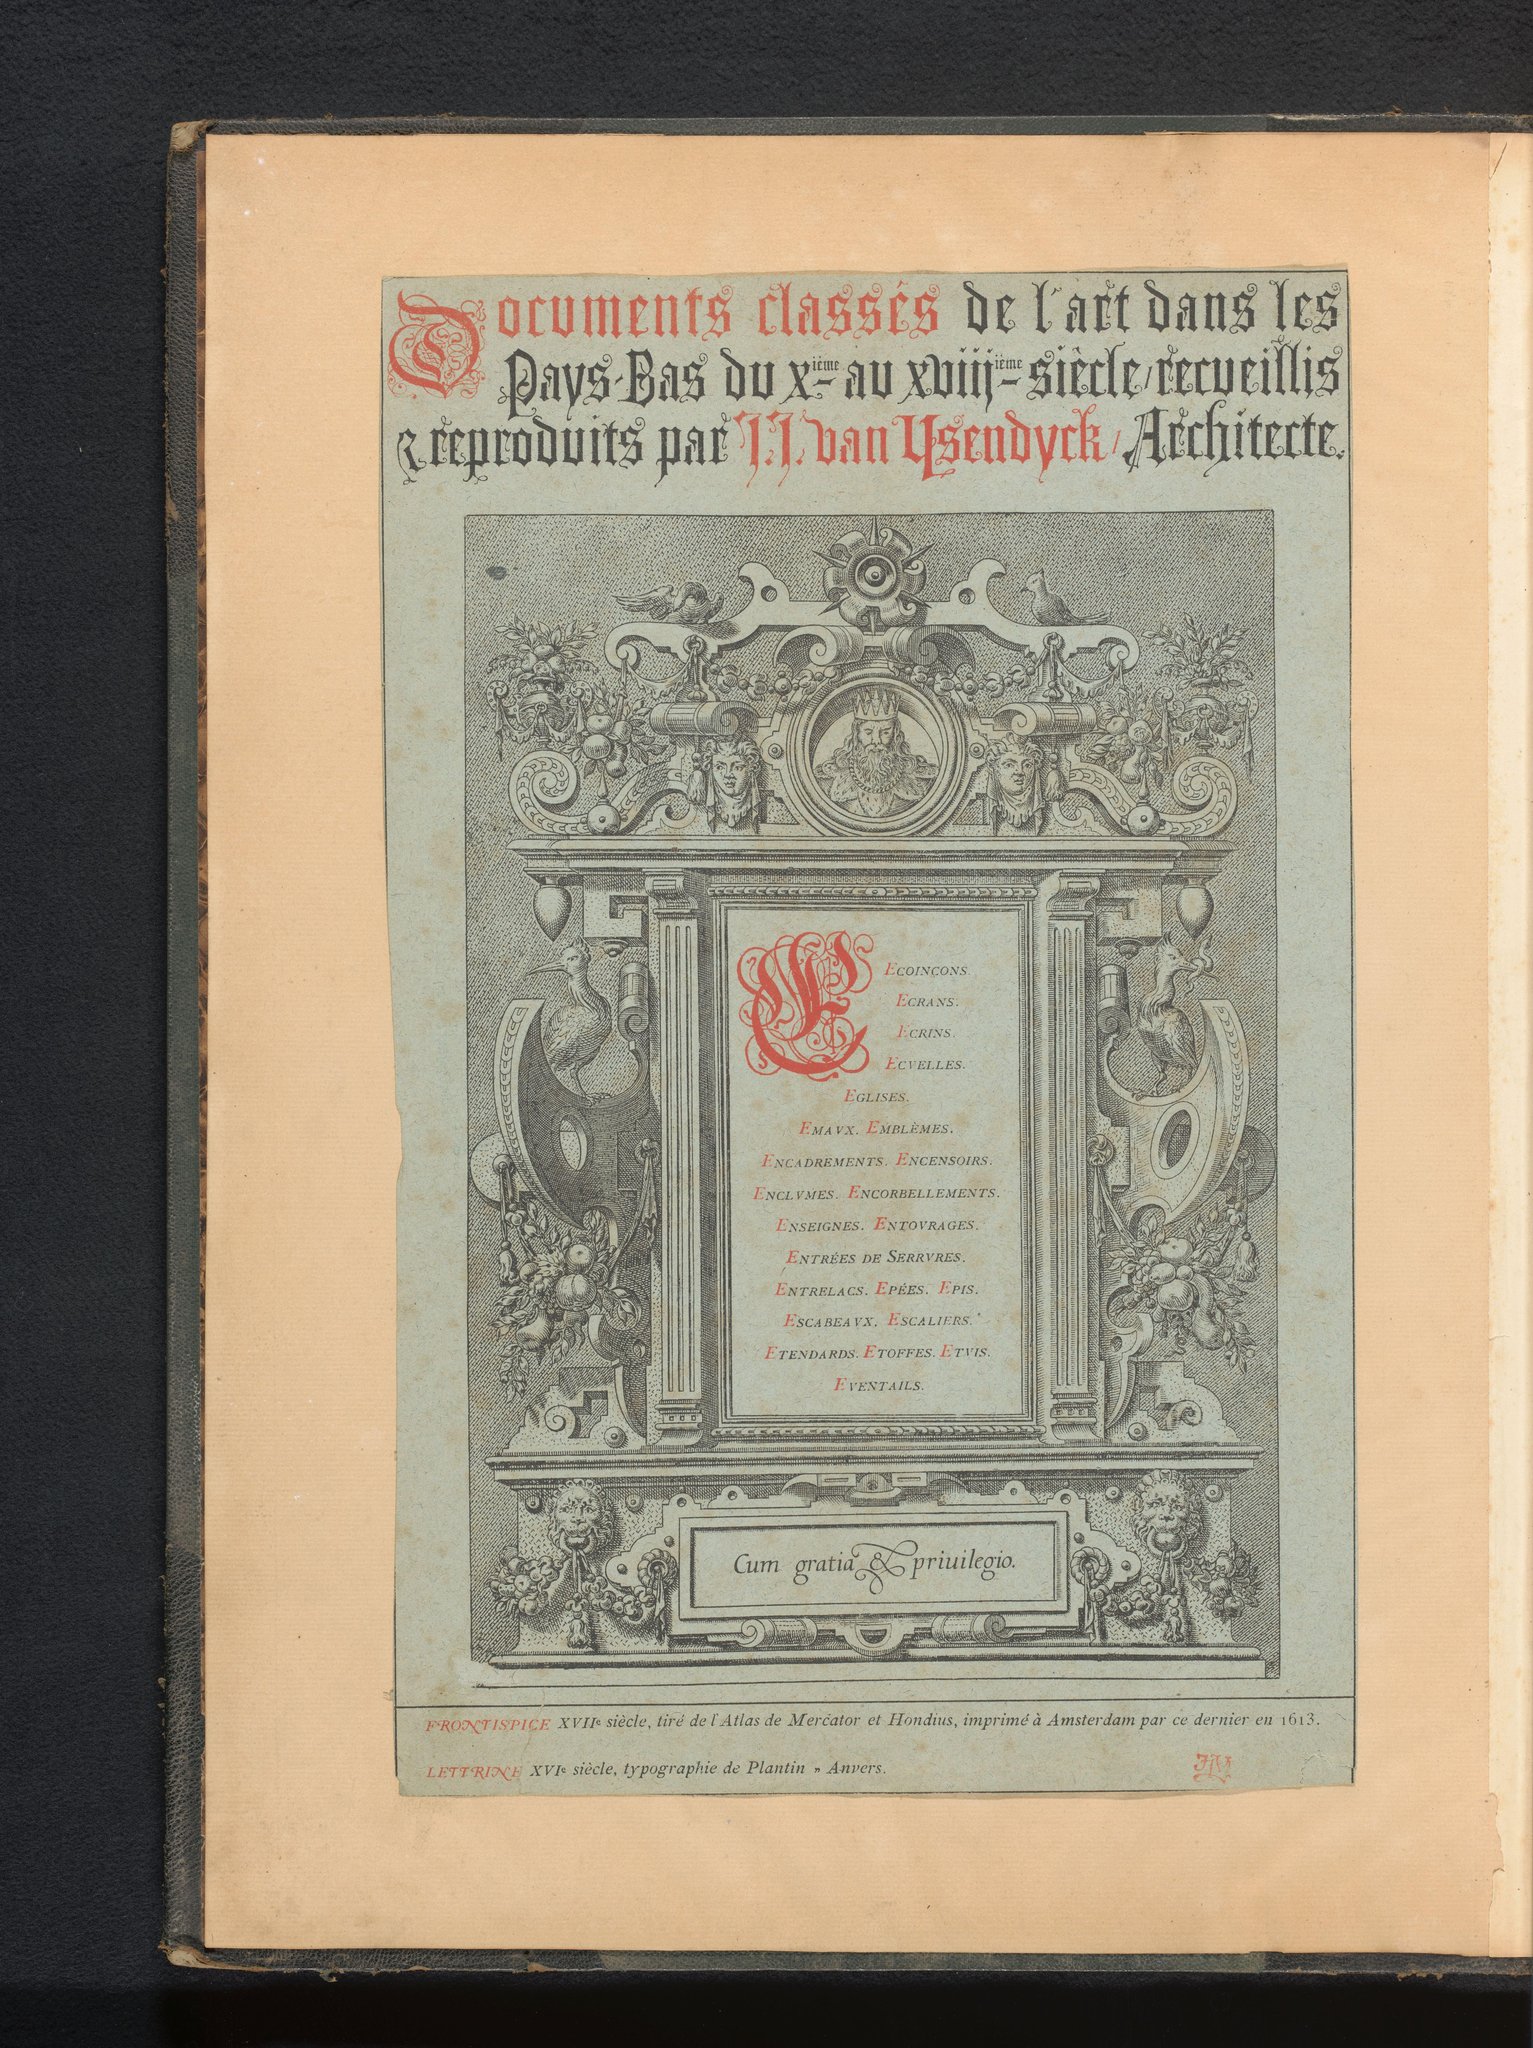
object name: photomechanical print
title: Reproductie van een titelpagina uit een Mercator-Hondius atlas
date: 1876-1881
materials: paper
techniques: photolithography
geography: antwerp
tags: title-page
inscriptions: inscription: ‘FRONTISPICE XVIIe siècle (...)’, monogram: ‘JJvY’